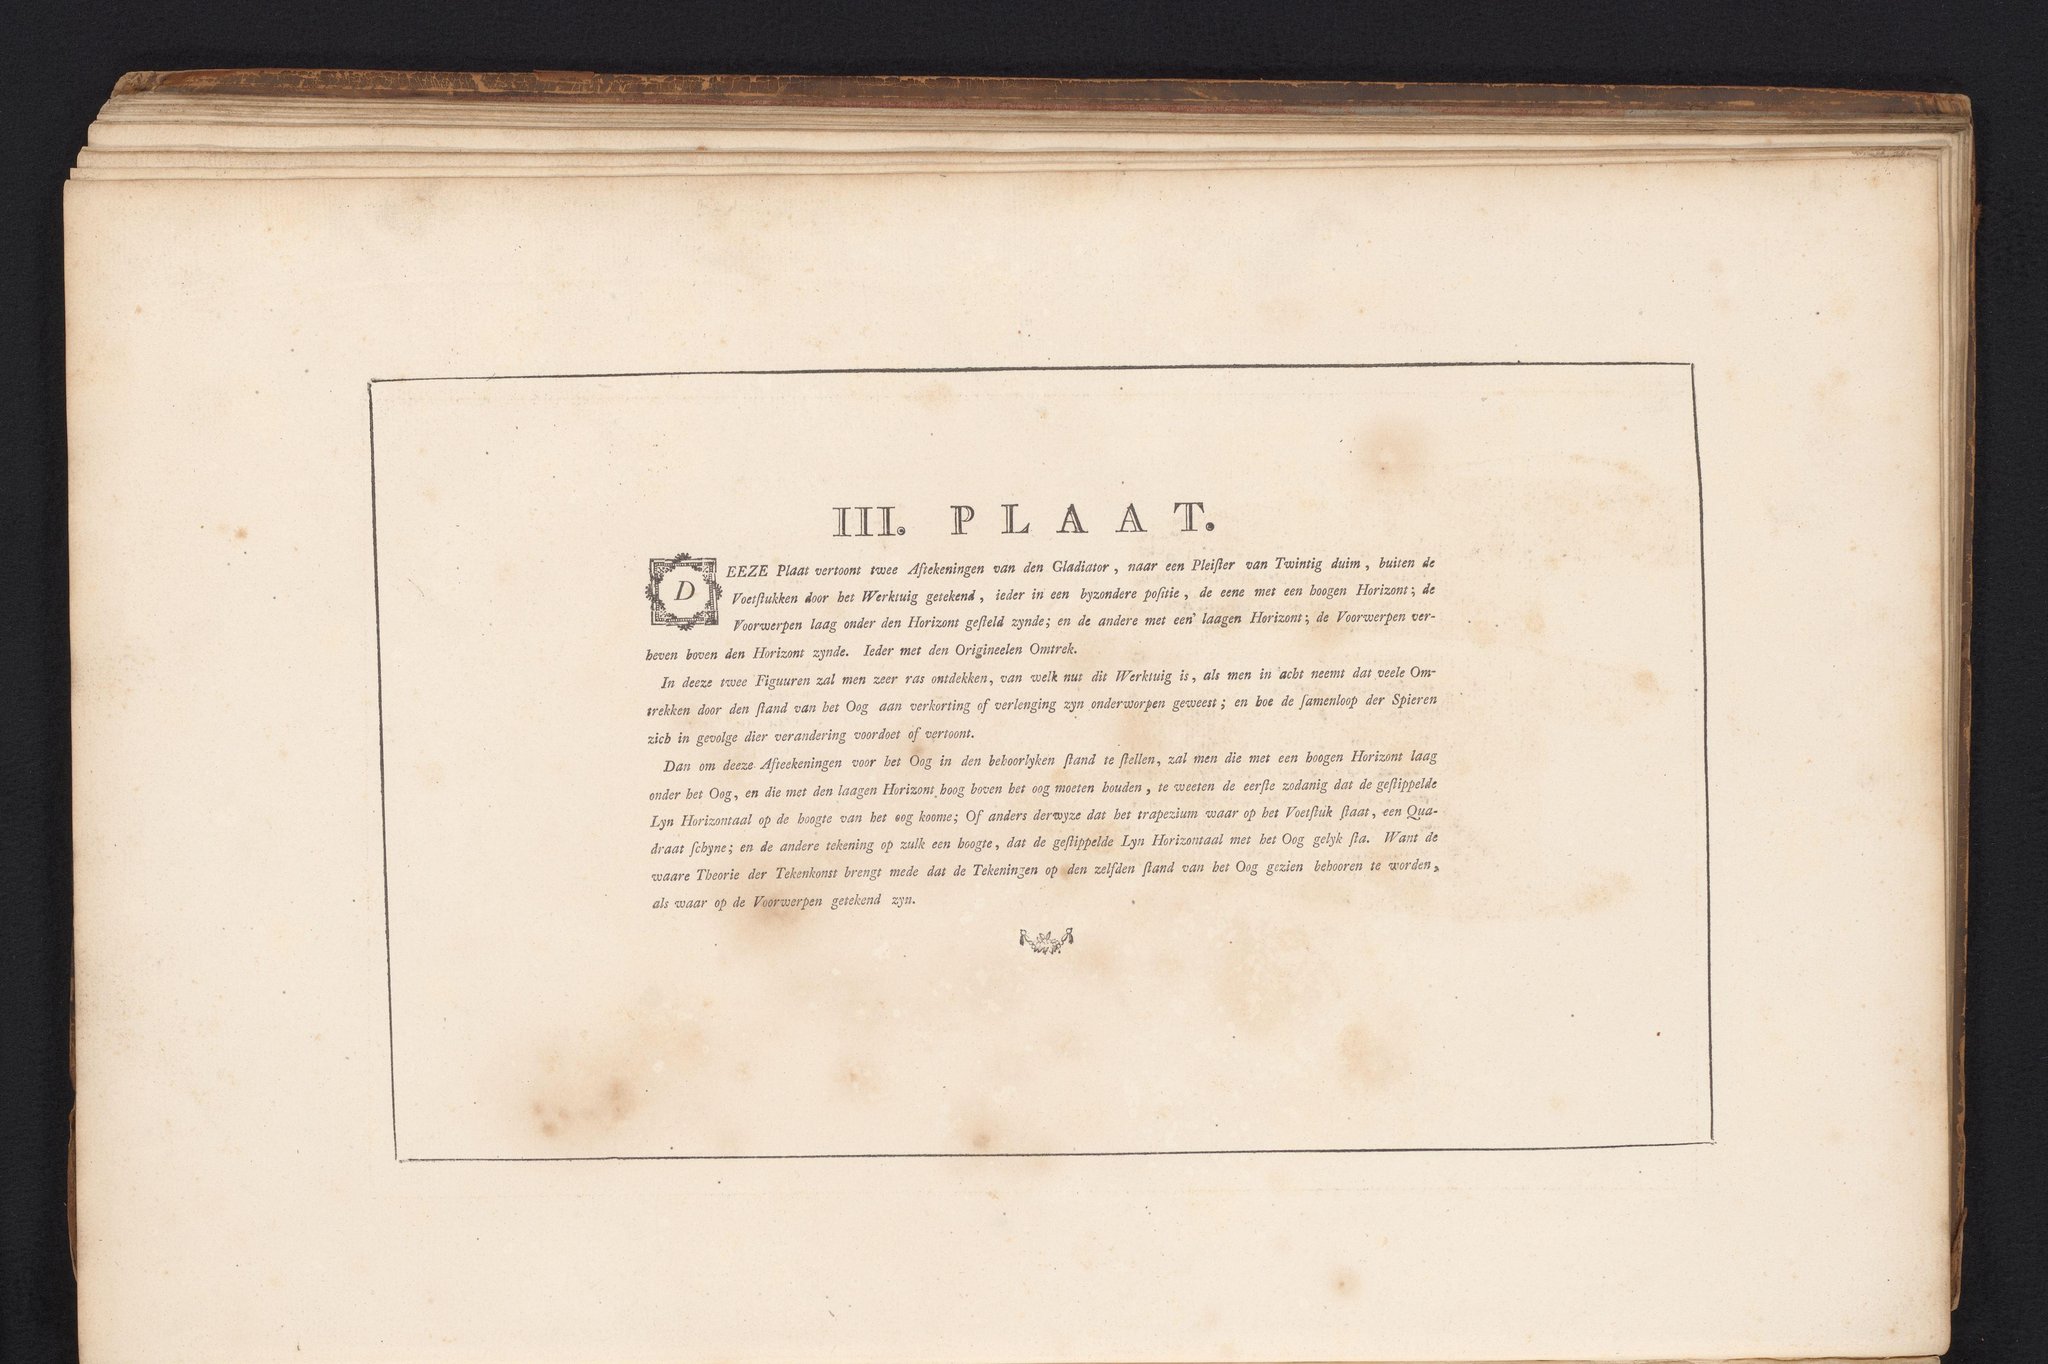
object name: text sheet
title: III. Plaat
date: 1777-1778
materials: paper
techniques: letterpress printing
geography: the hague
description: Tekstblad met een Nederlandstalige toelichting op een prent met een voorstelling van twee gladiatoren, getekend met een hoge en een lage horizon en eerst alleen in omtrek met behulp van een grafometer. Het tekstblad maakt deel uit van het boek: A.G. Eckhardt, Beschryving van een algemeenen graphometer, 1778.